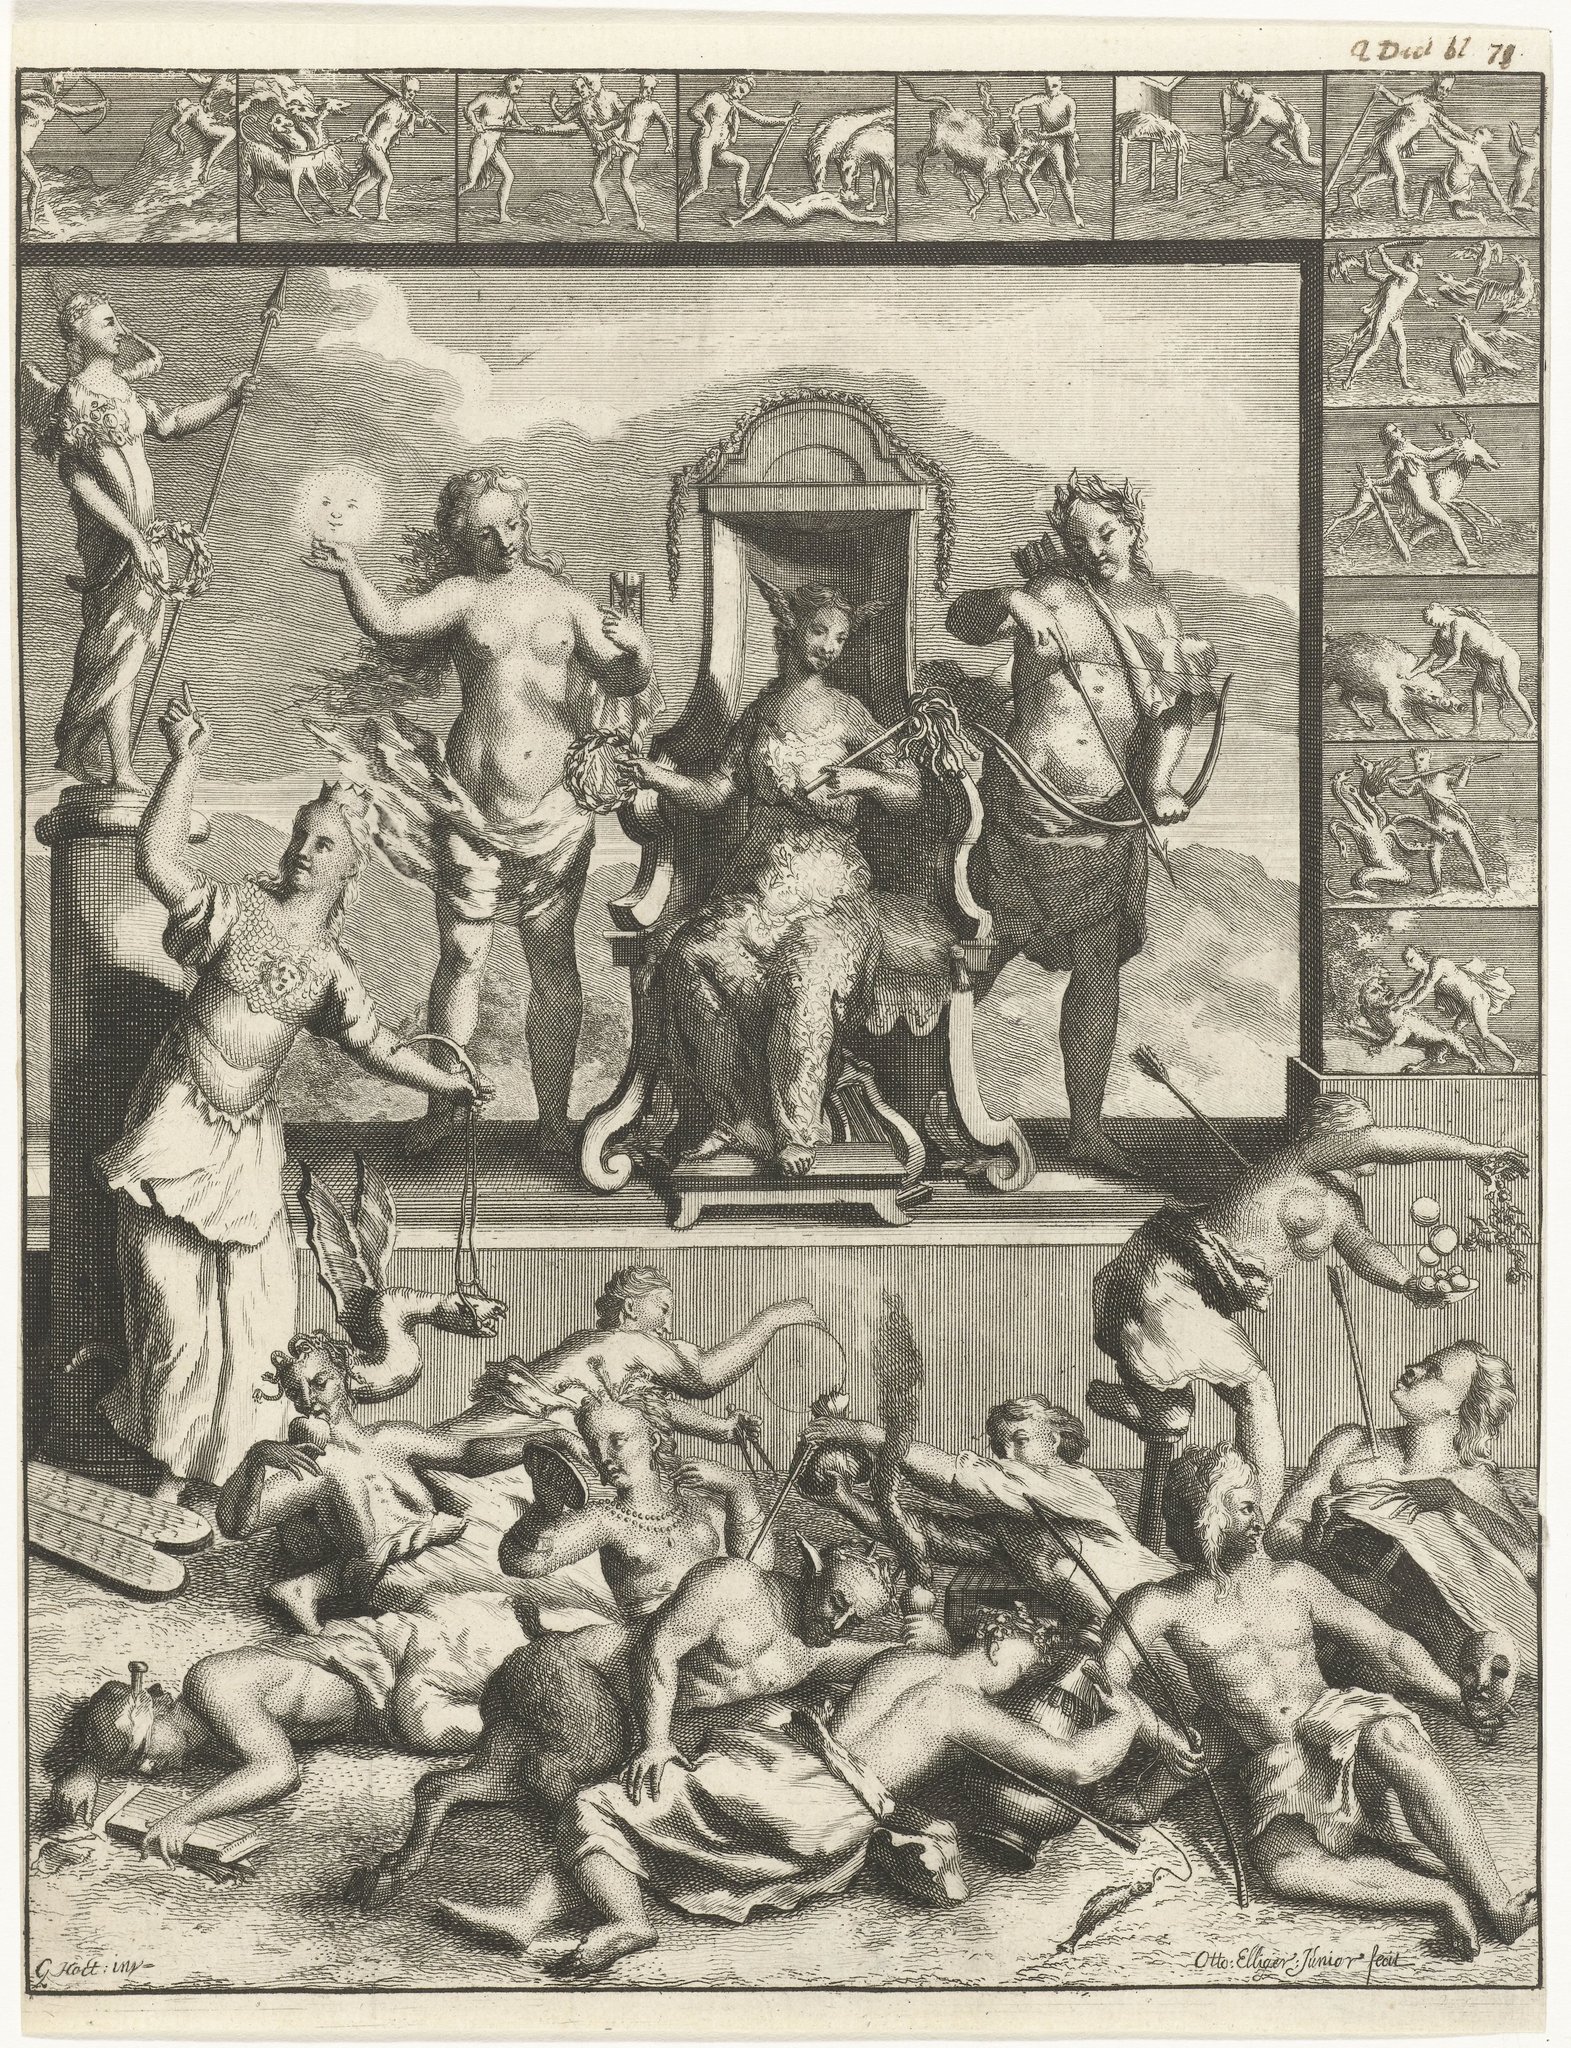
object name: print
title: Allegorische voorstelling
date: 1676-1735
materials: paper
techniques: engraving, etching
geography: netherlands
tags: most important deeds of hercules: the twelve labours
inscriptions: collector's mark: Lugt 2228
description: Op een podium zit een vrouw met staf en lauwerkrans in haar handen. Ze wordt vergezeld door een naakte vrouw met zandloper en een man die pijlen schiet naar de personificaties van verschillende zonden. Een vrouw met een gevleugelde slang wijst omhoog naar een kader met de twaalf werken van Hercules.